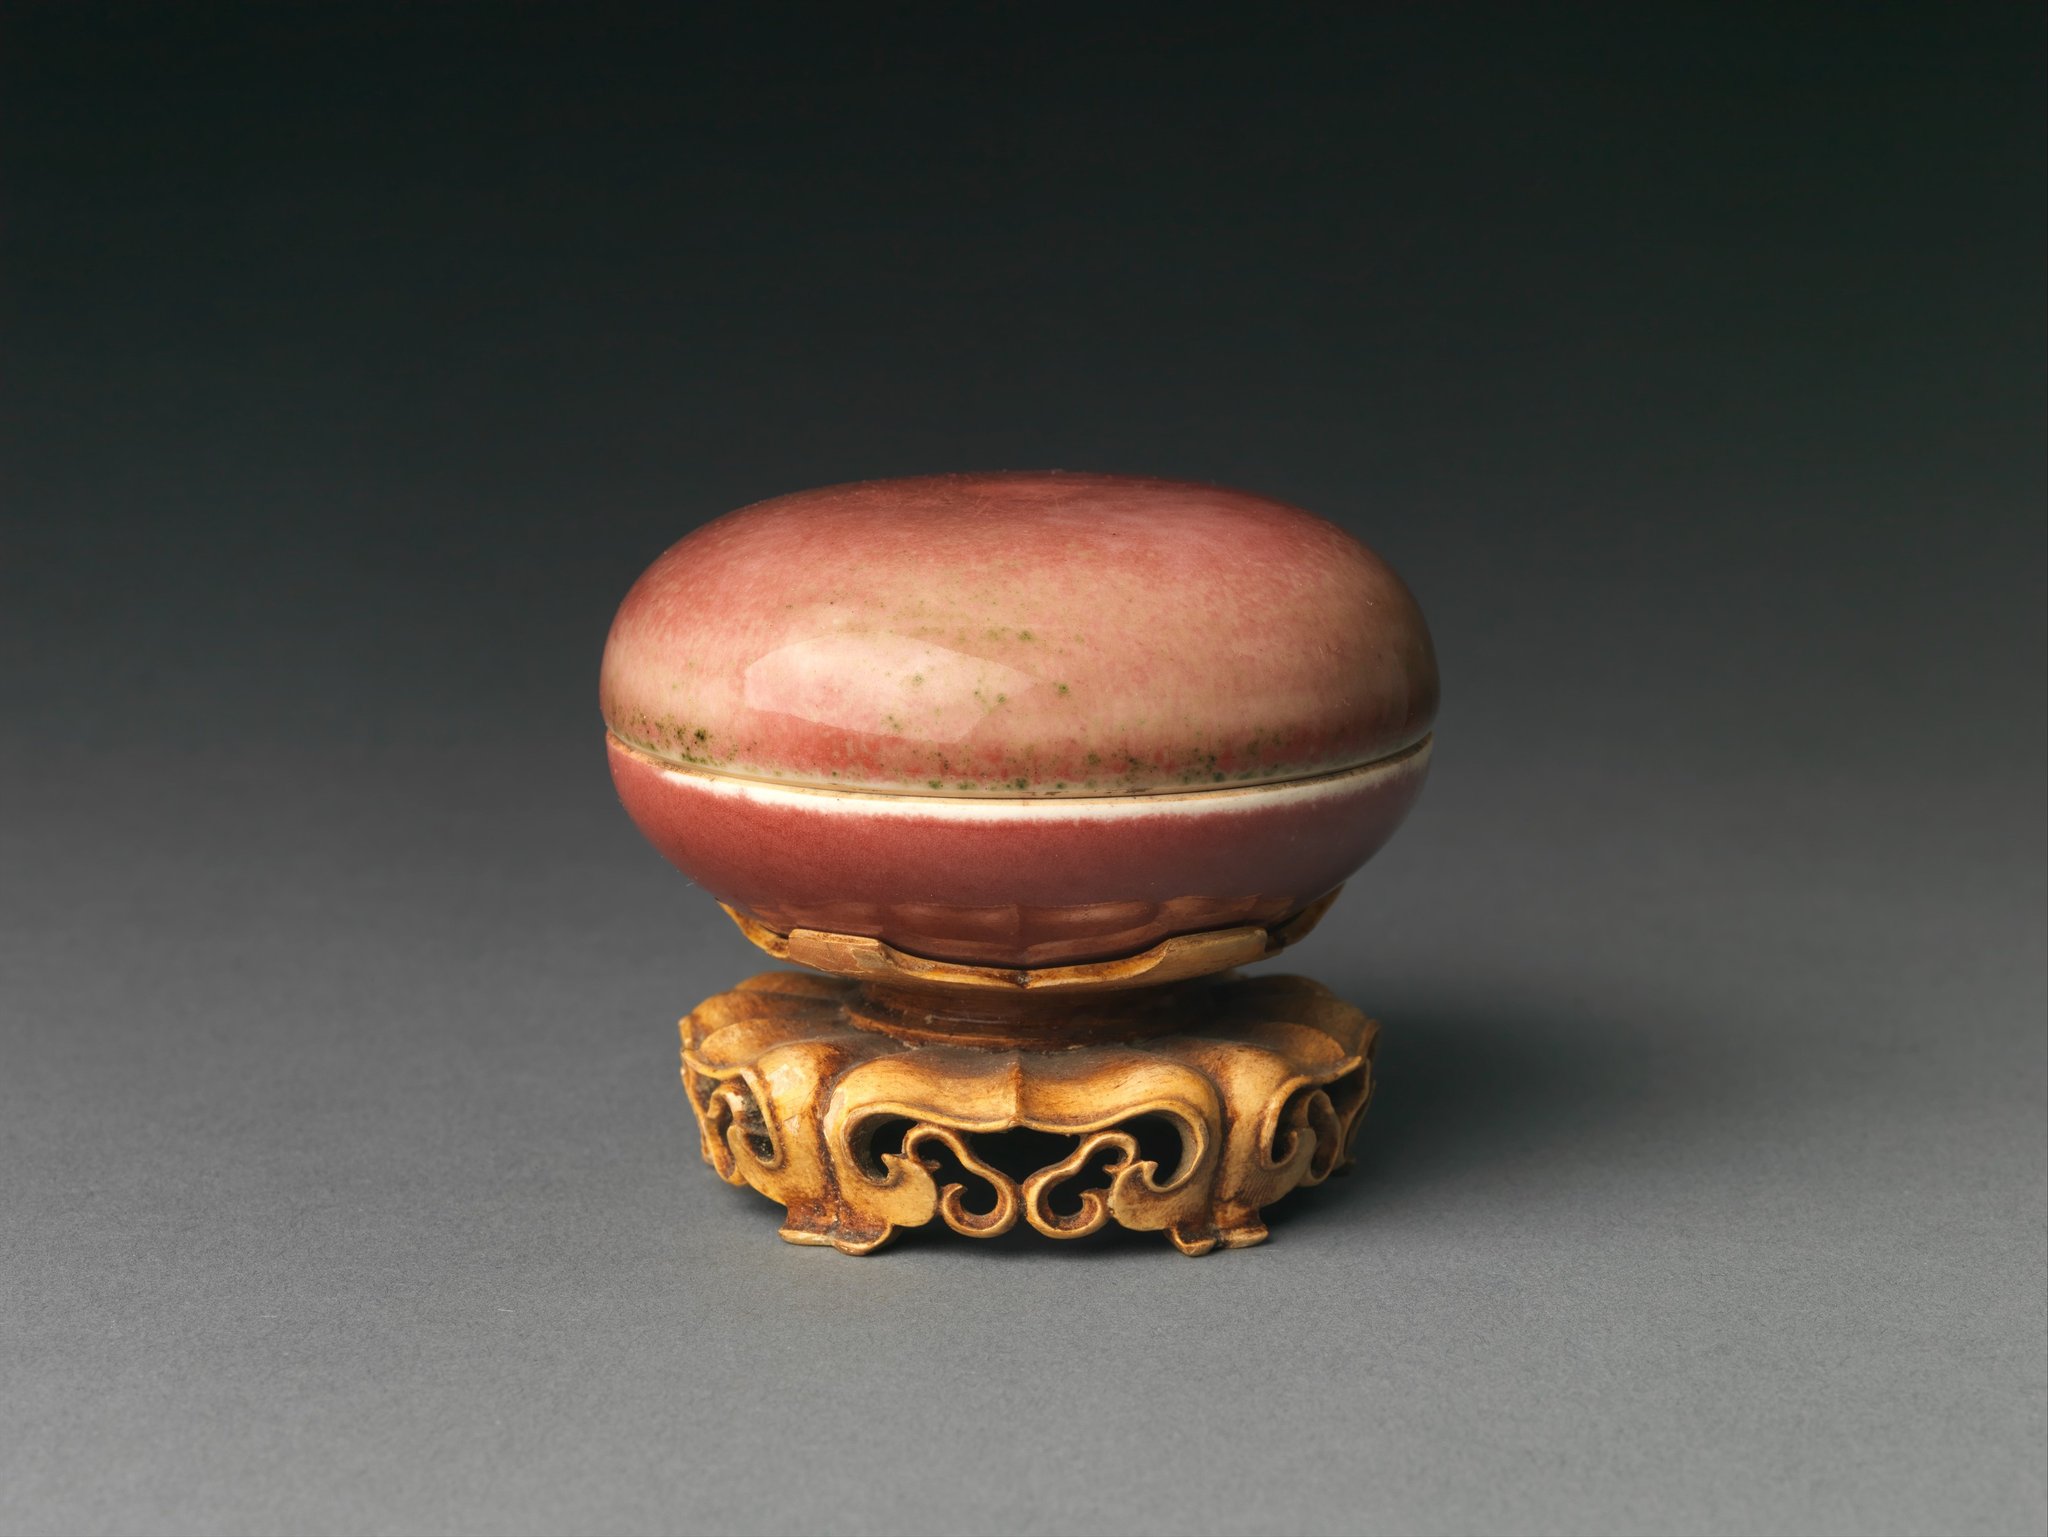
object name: box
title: Rouge Box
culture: chinese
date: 1662-1722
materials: glaze, porcelain